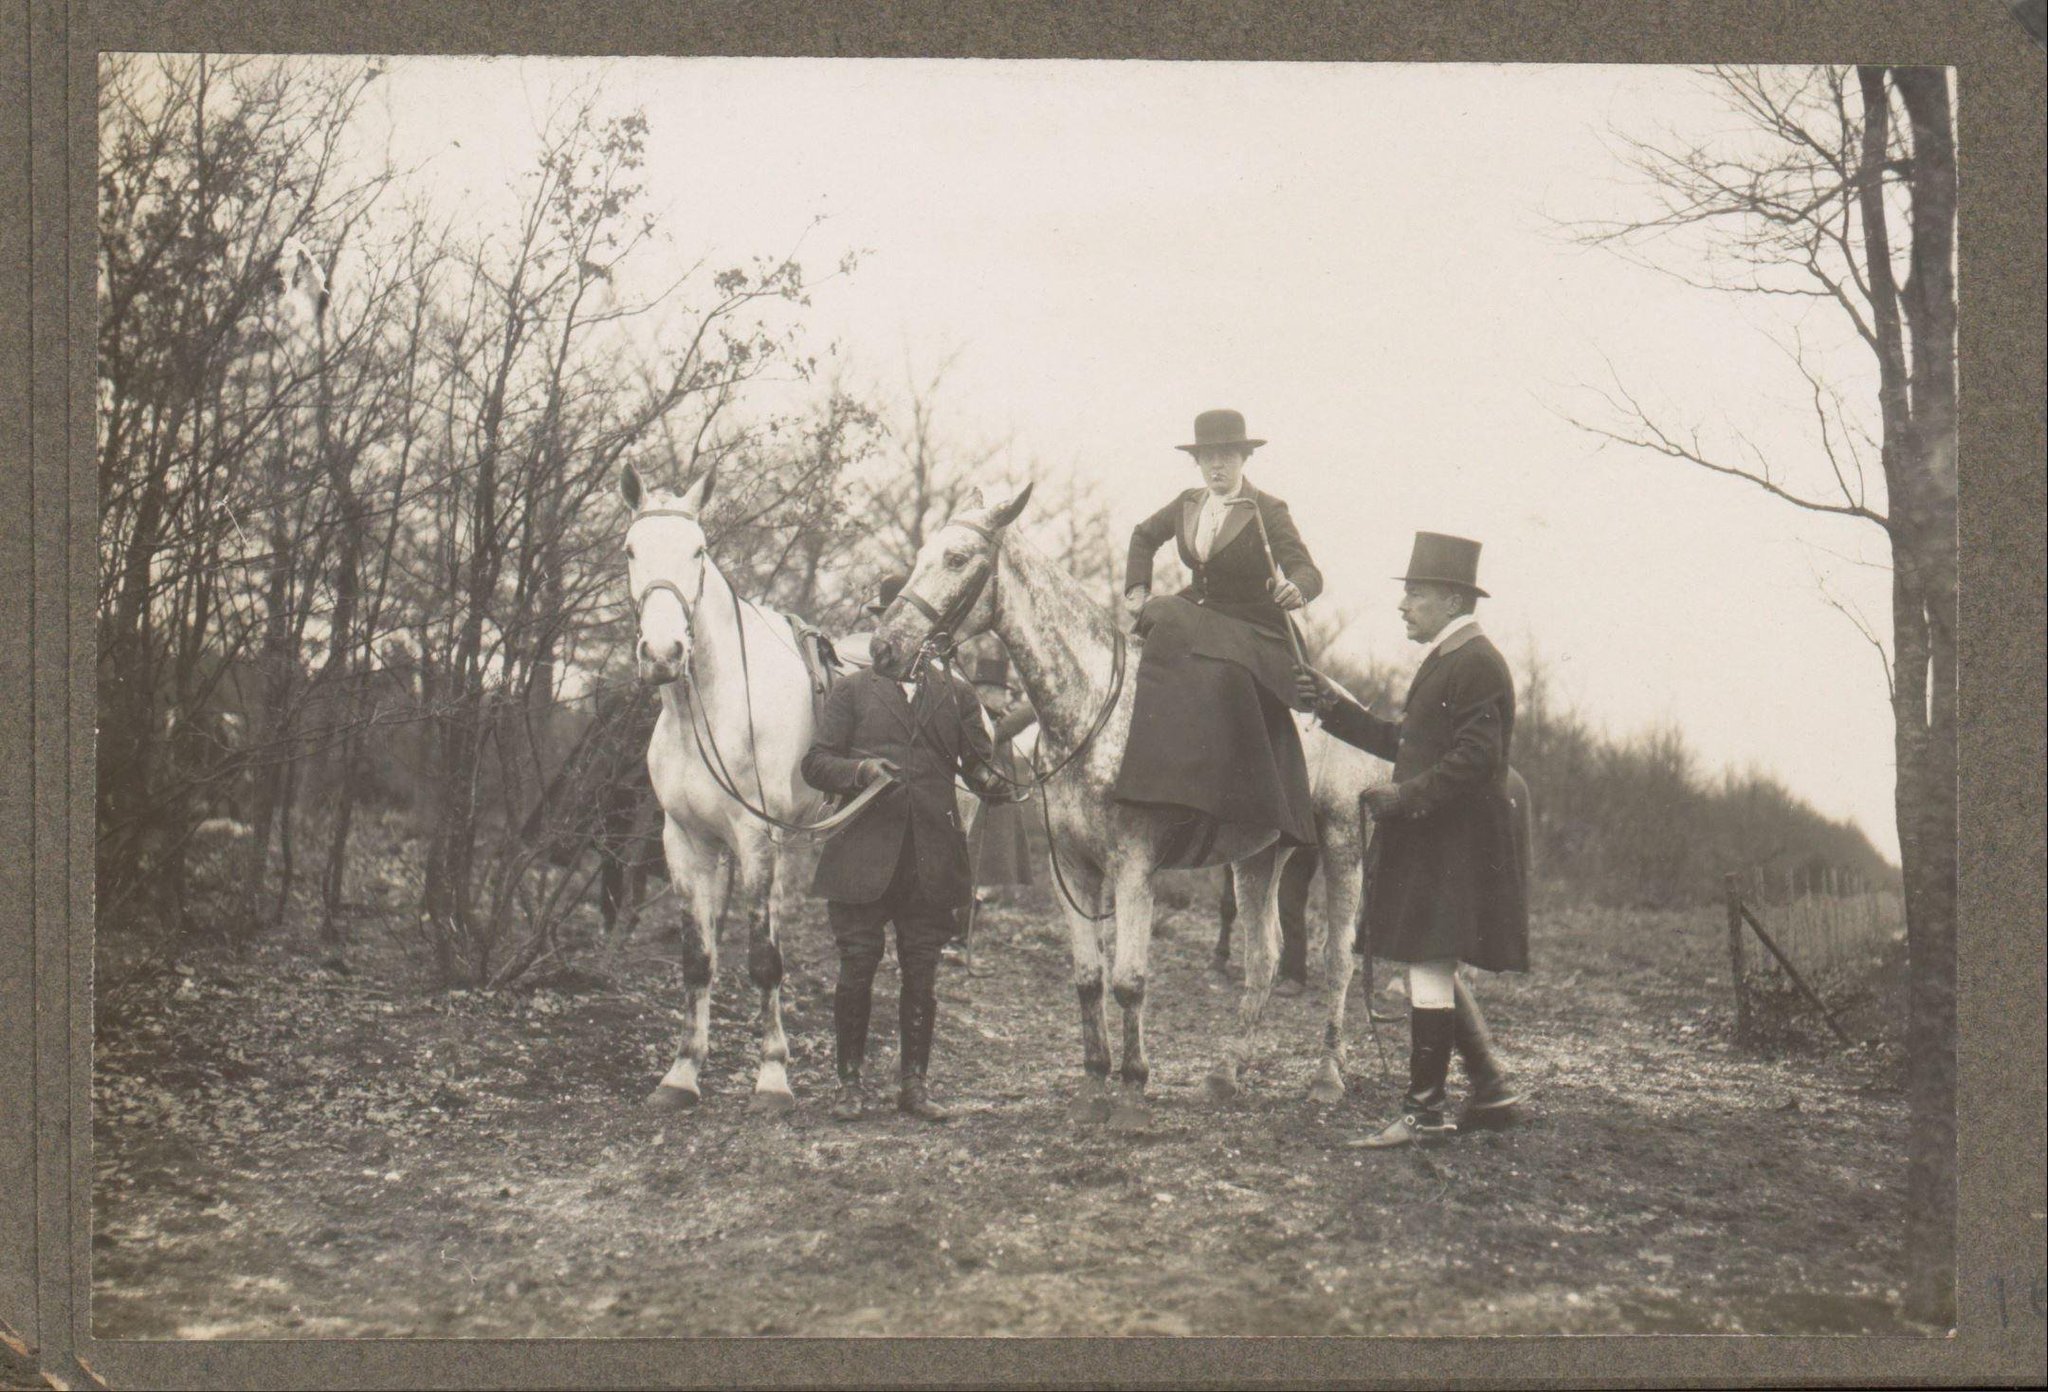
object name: photograph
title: Ruitertafereel op Koninklijke Houtvesterij Het Loo: vrouw krijgt hulp van man bij afstijgen van paard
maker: Anonymous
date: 1900-1925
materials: photographic support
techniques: gelatin silver print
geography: het loo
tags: riding a horse, ass, or mule; rider, horseman, hunting, chase, hunting-ground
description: Onderdeel van Fotoalbum van de heer Brams, opperhoutvester van koningin Wilhelmina op Koninklijke Houtvesterij Het Loo.